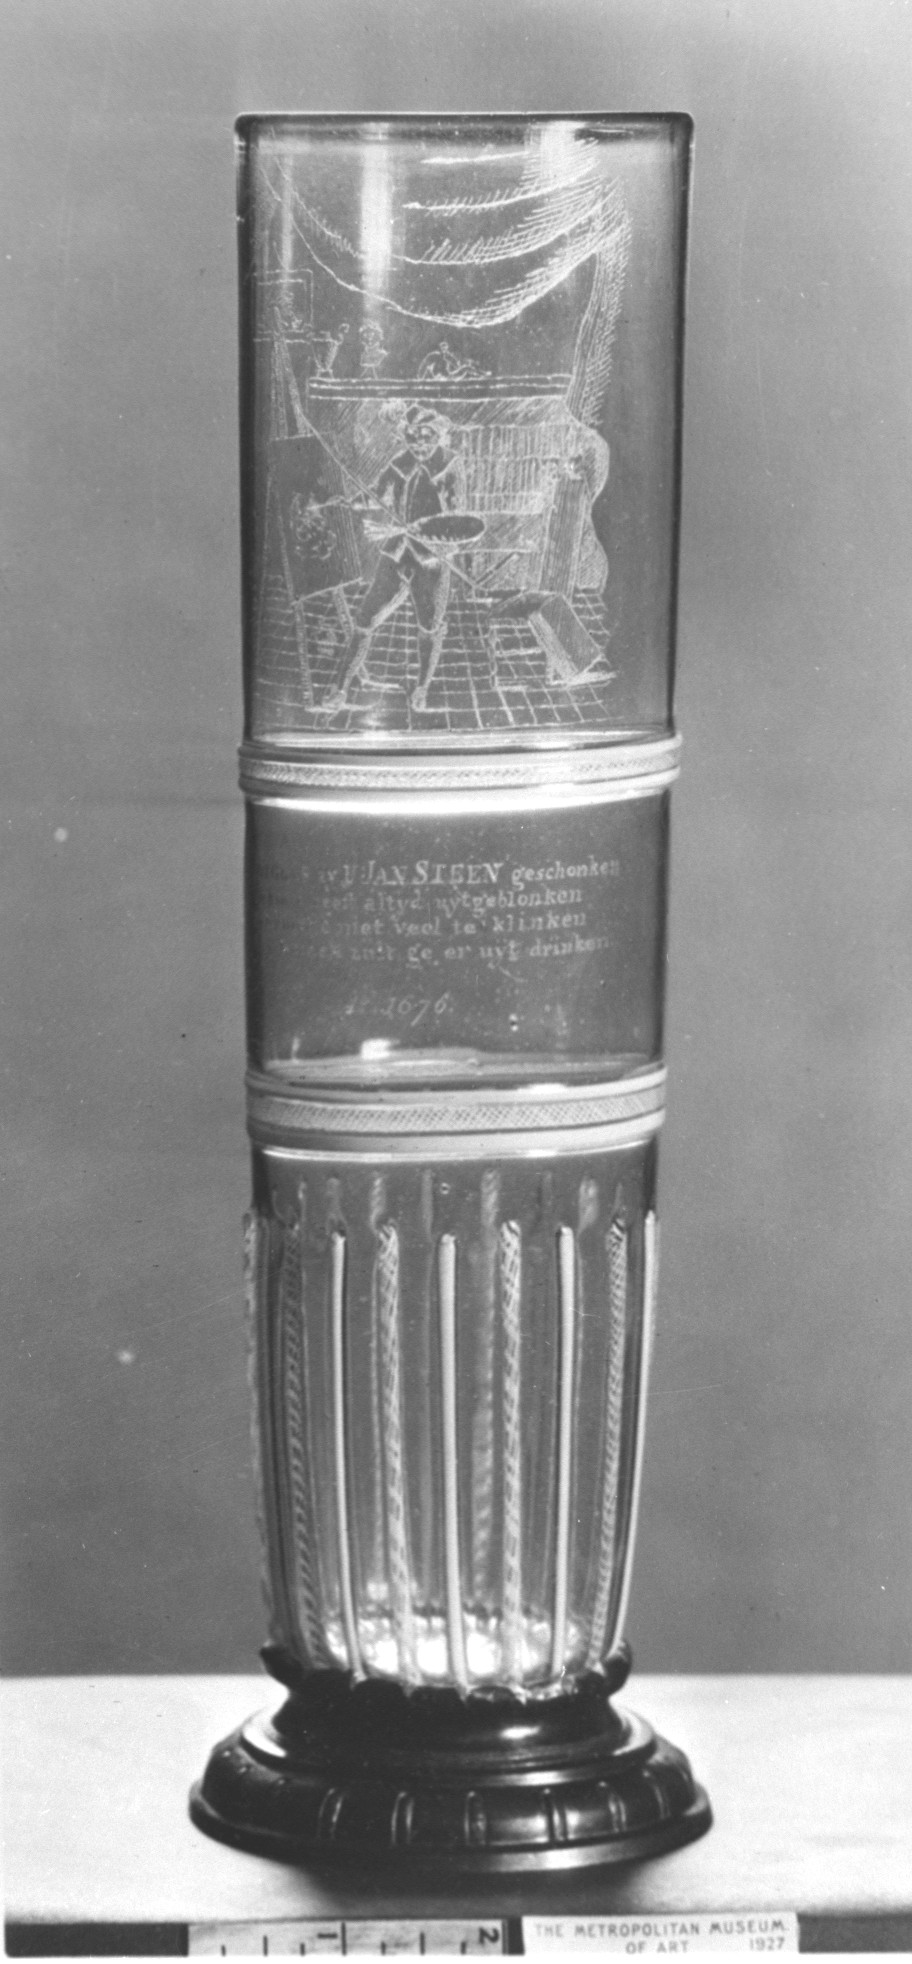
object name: pole glass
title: Pole glass (Stangenglas)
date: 1601-1700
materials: glass, silver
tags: painting,men